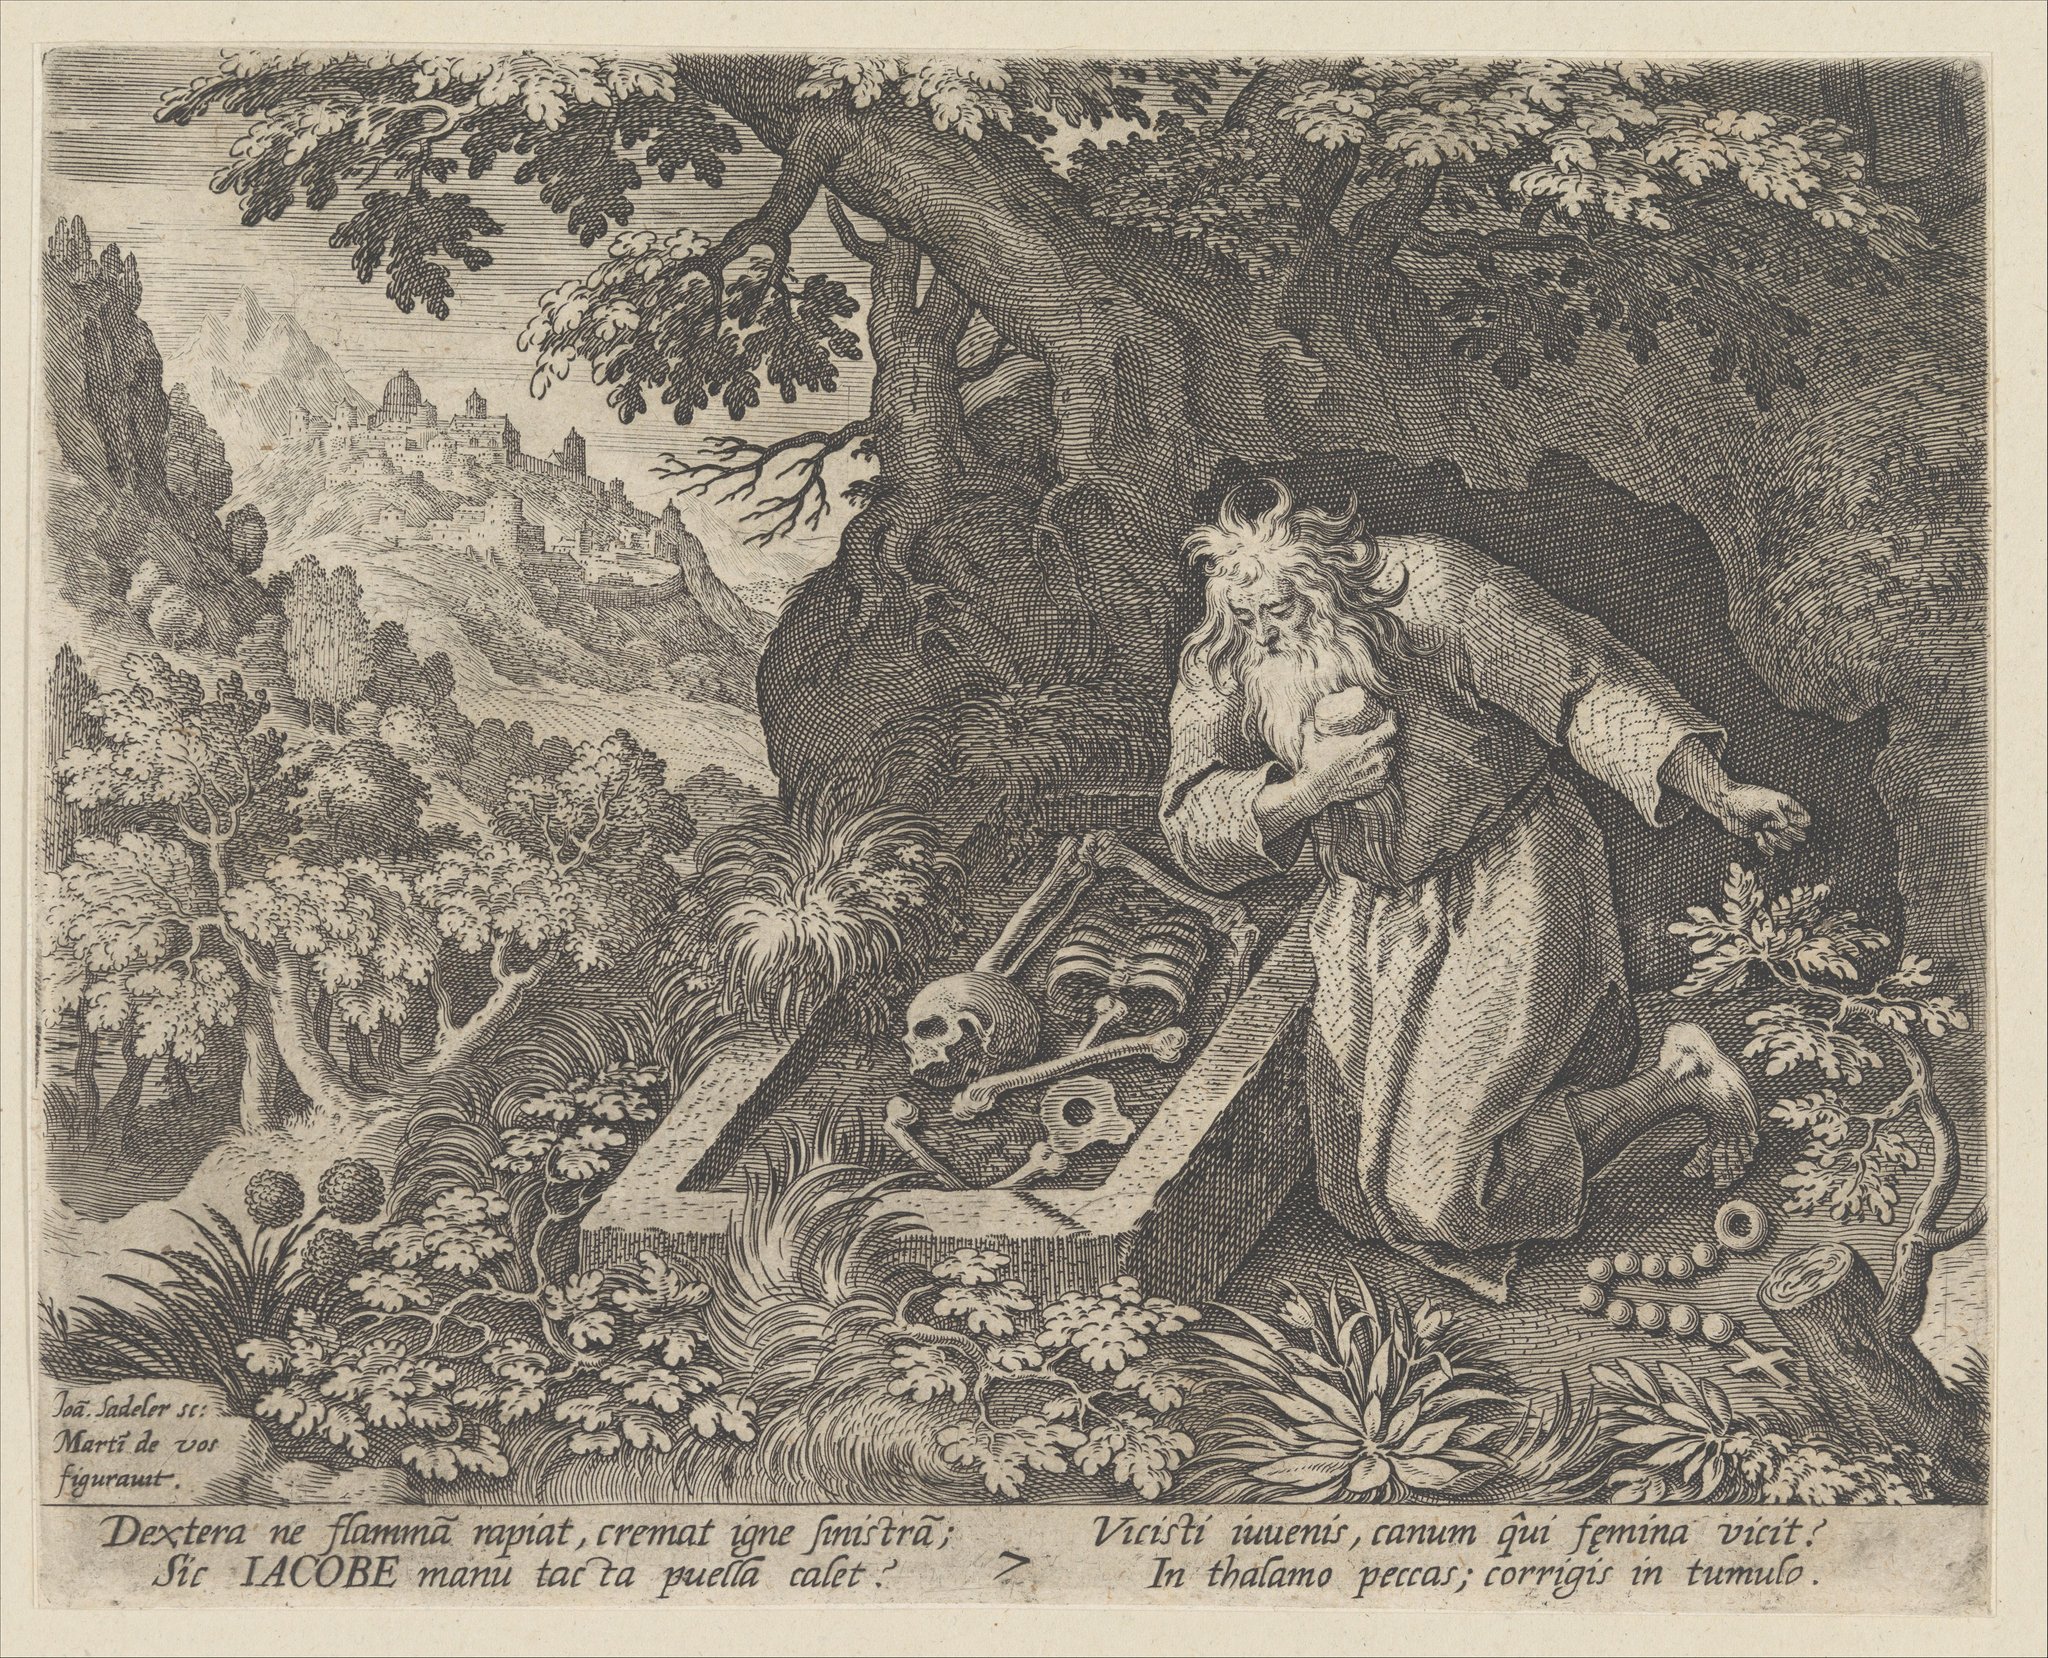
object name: print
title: Jacob, from "Sylvae Sacrae Monumenta...Anachoretarum"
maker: johann sadeler (i)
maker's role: artist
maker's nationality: netherlandish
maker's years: 1550-1601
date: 1593-1594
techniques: engraving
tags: skulls,men,trees